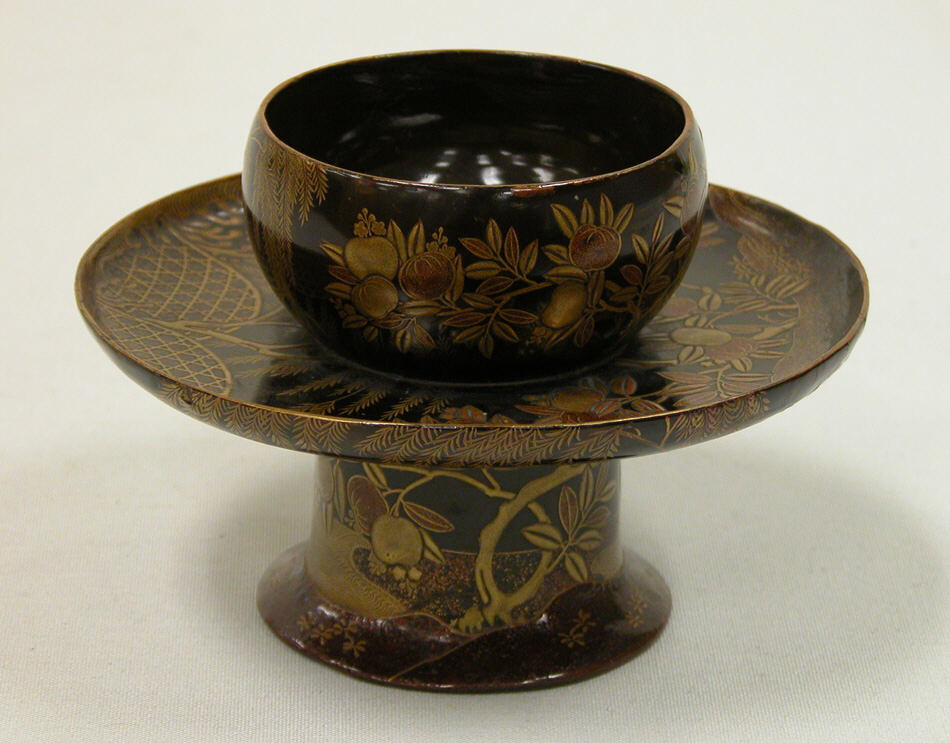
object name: cup stand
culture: japanese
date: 1615-1868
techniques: maki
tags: fruit